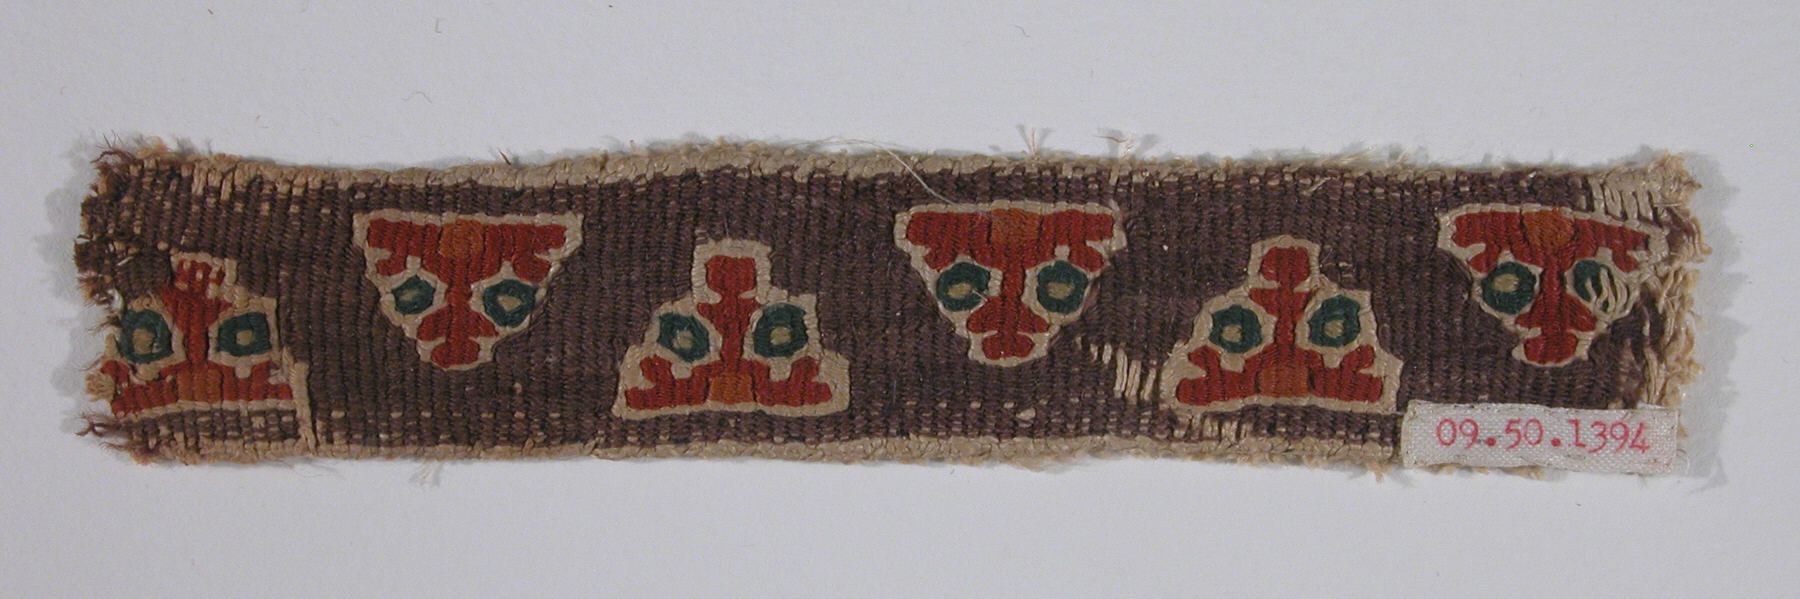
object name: band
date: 401-600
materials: linen, wool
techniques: weave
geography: egypt